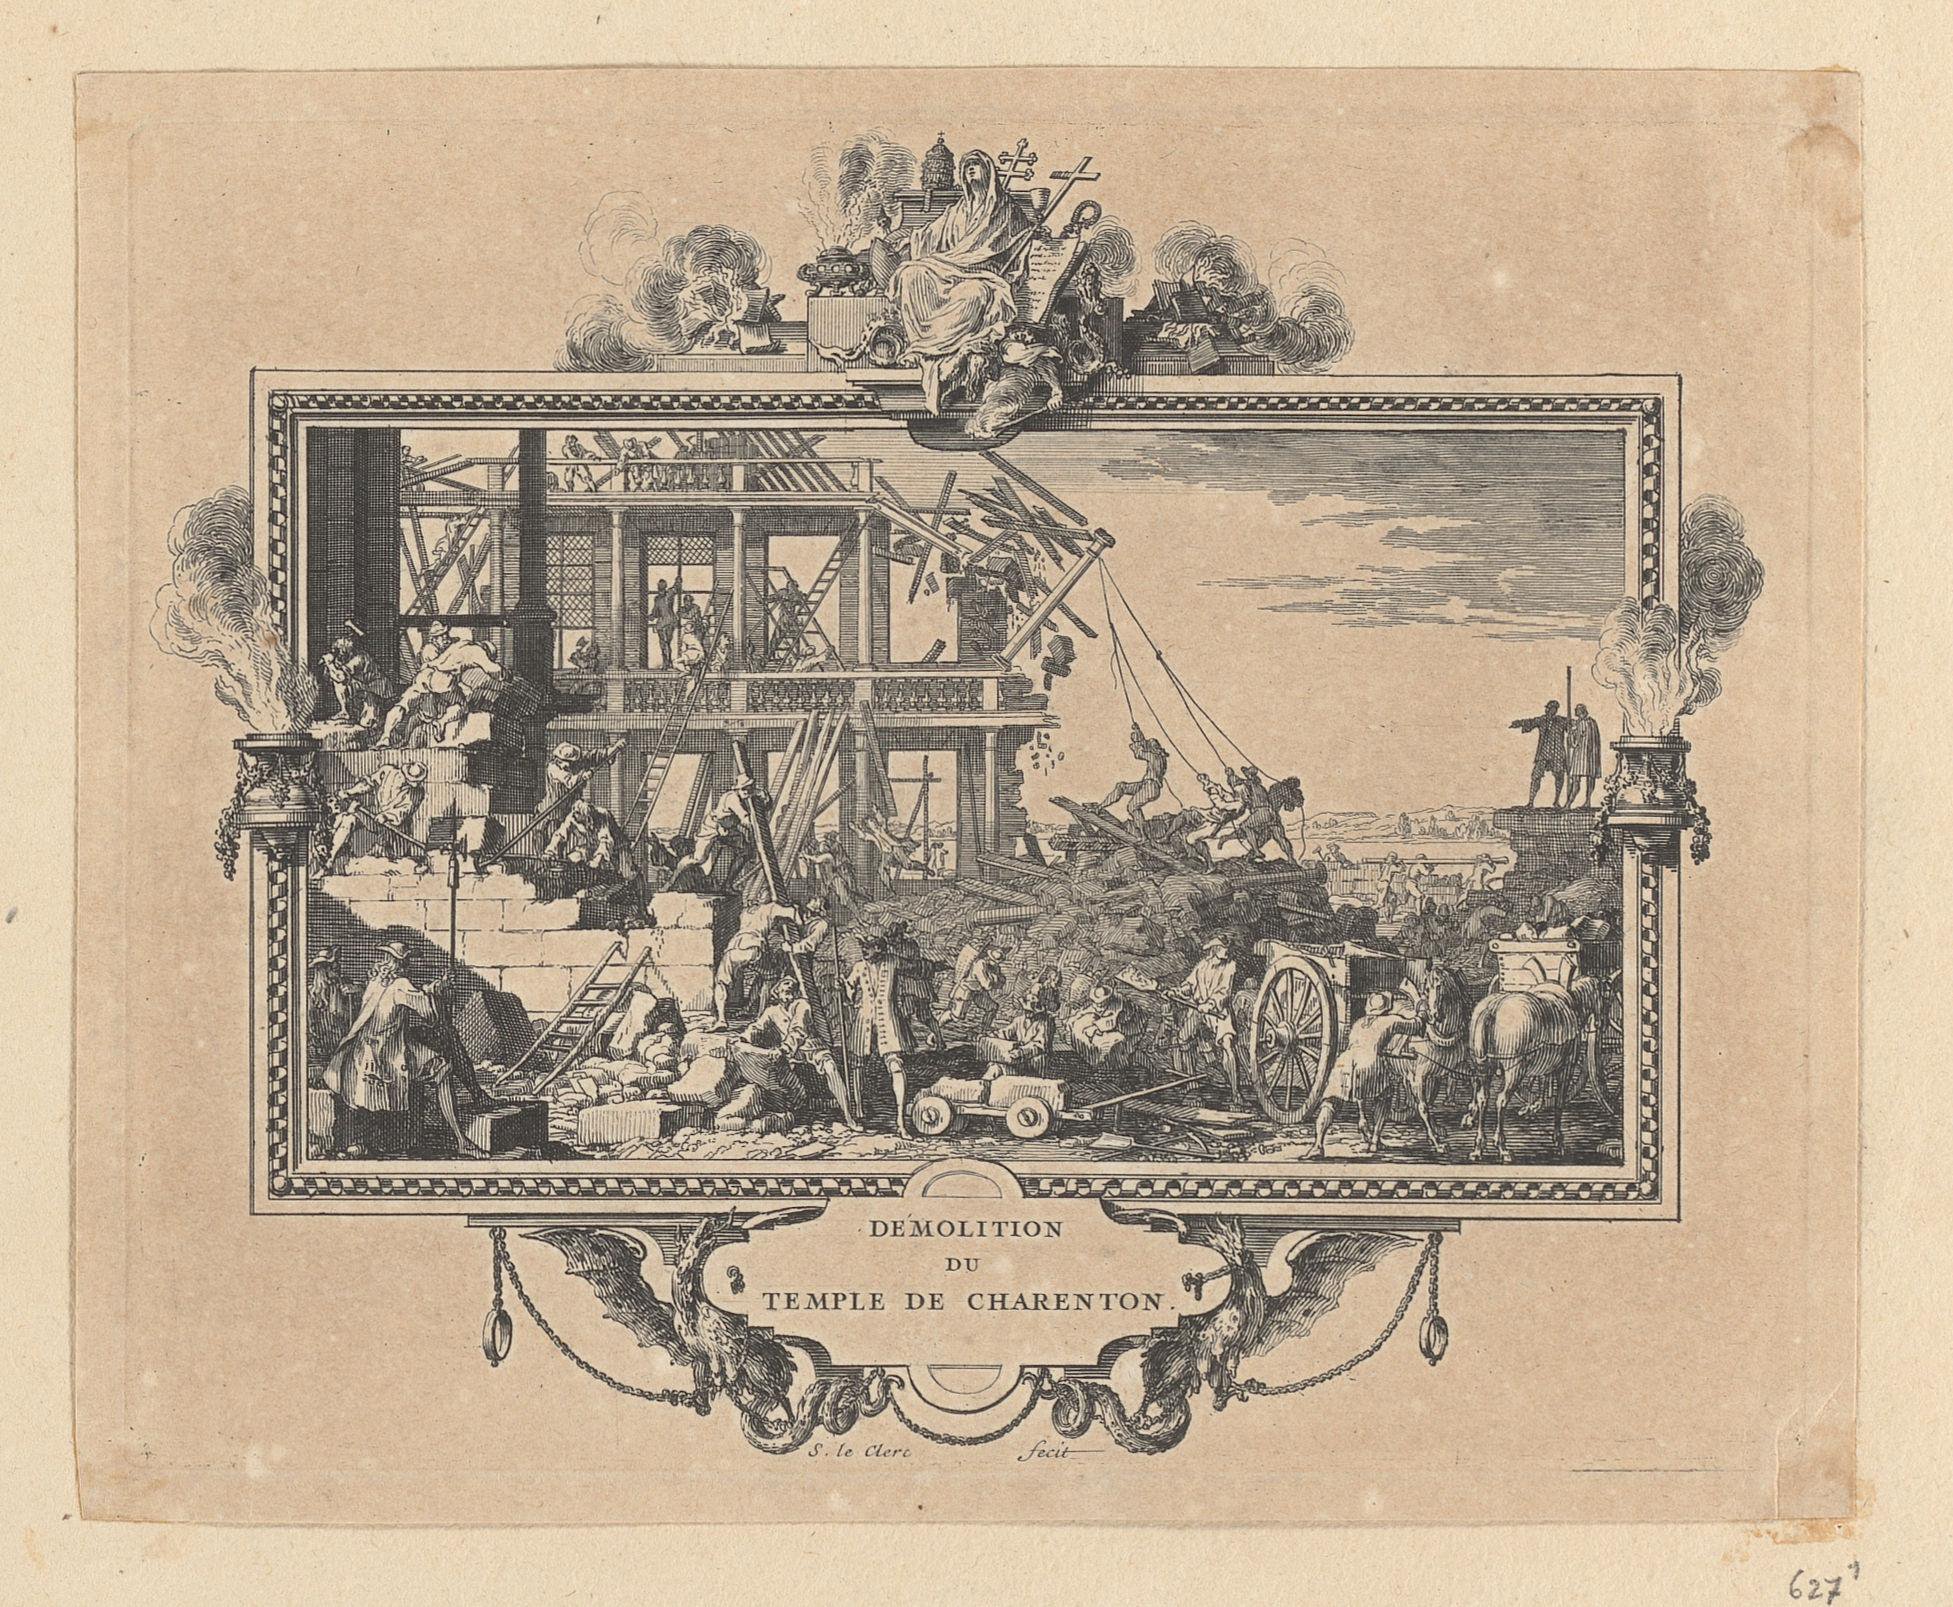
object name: album leaf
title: Petites conquêtes du Roi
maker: sébastien leclerc (i)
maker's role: print maker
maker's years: 1637-1714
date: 1702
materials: paper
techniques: engraving, etching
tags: aggression against the church, protestant churches and denominations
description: Protestantse tempel wordt verwoest na herroeping van het Edict van Nantes. Prent maakt deel uit van een album.